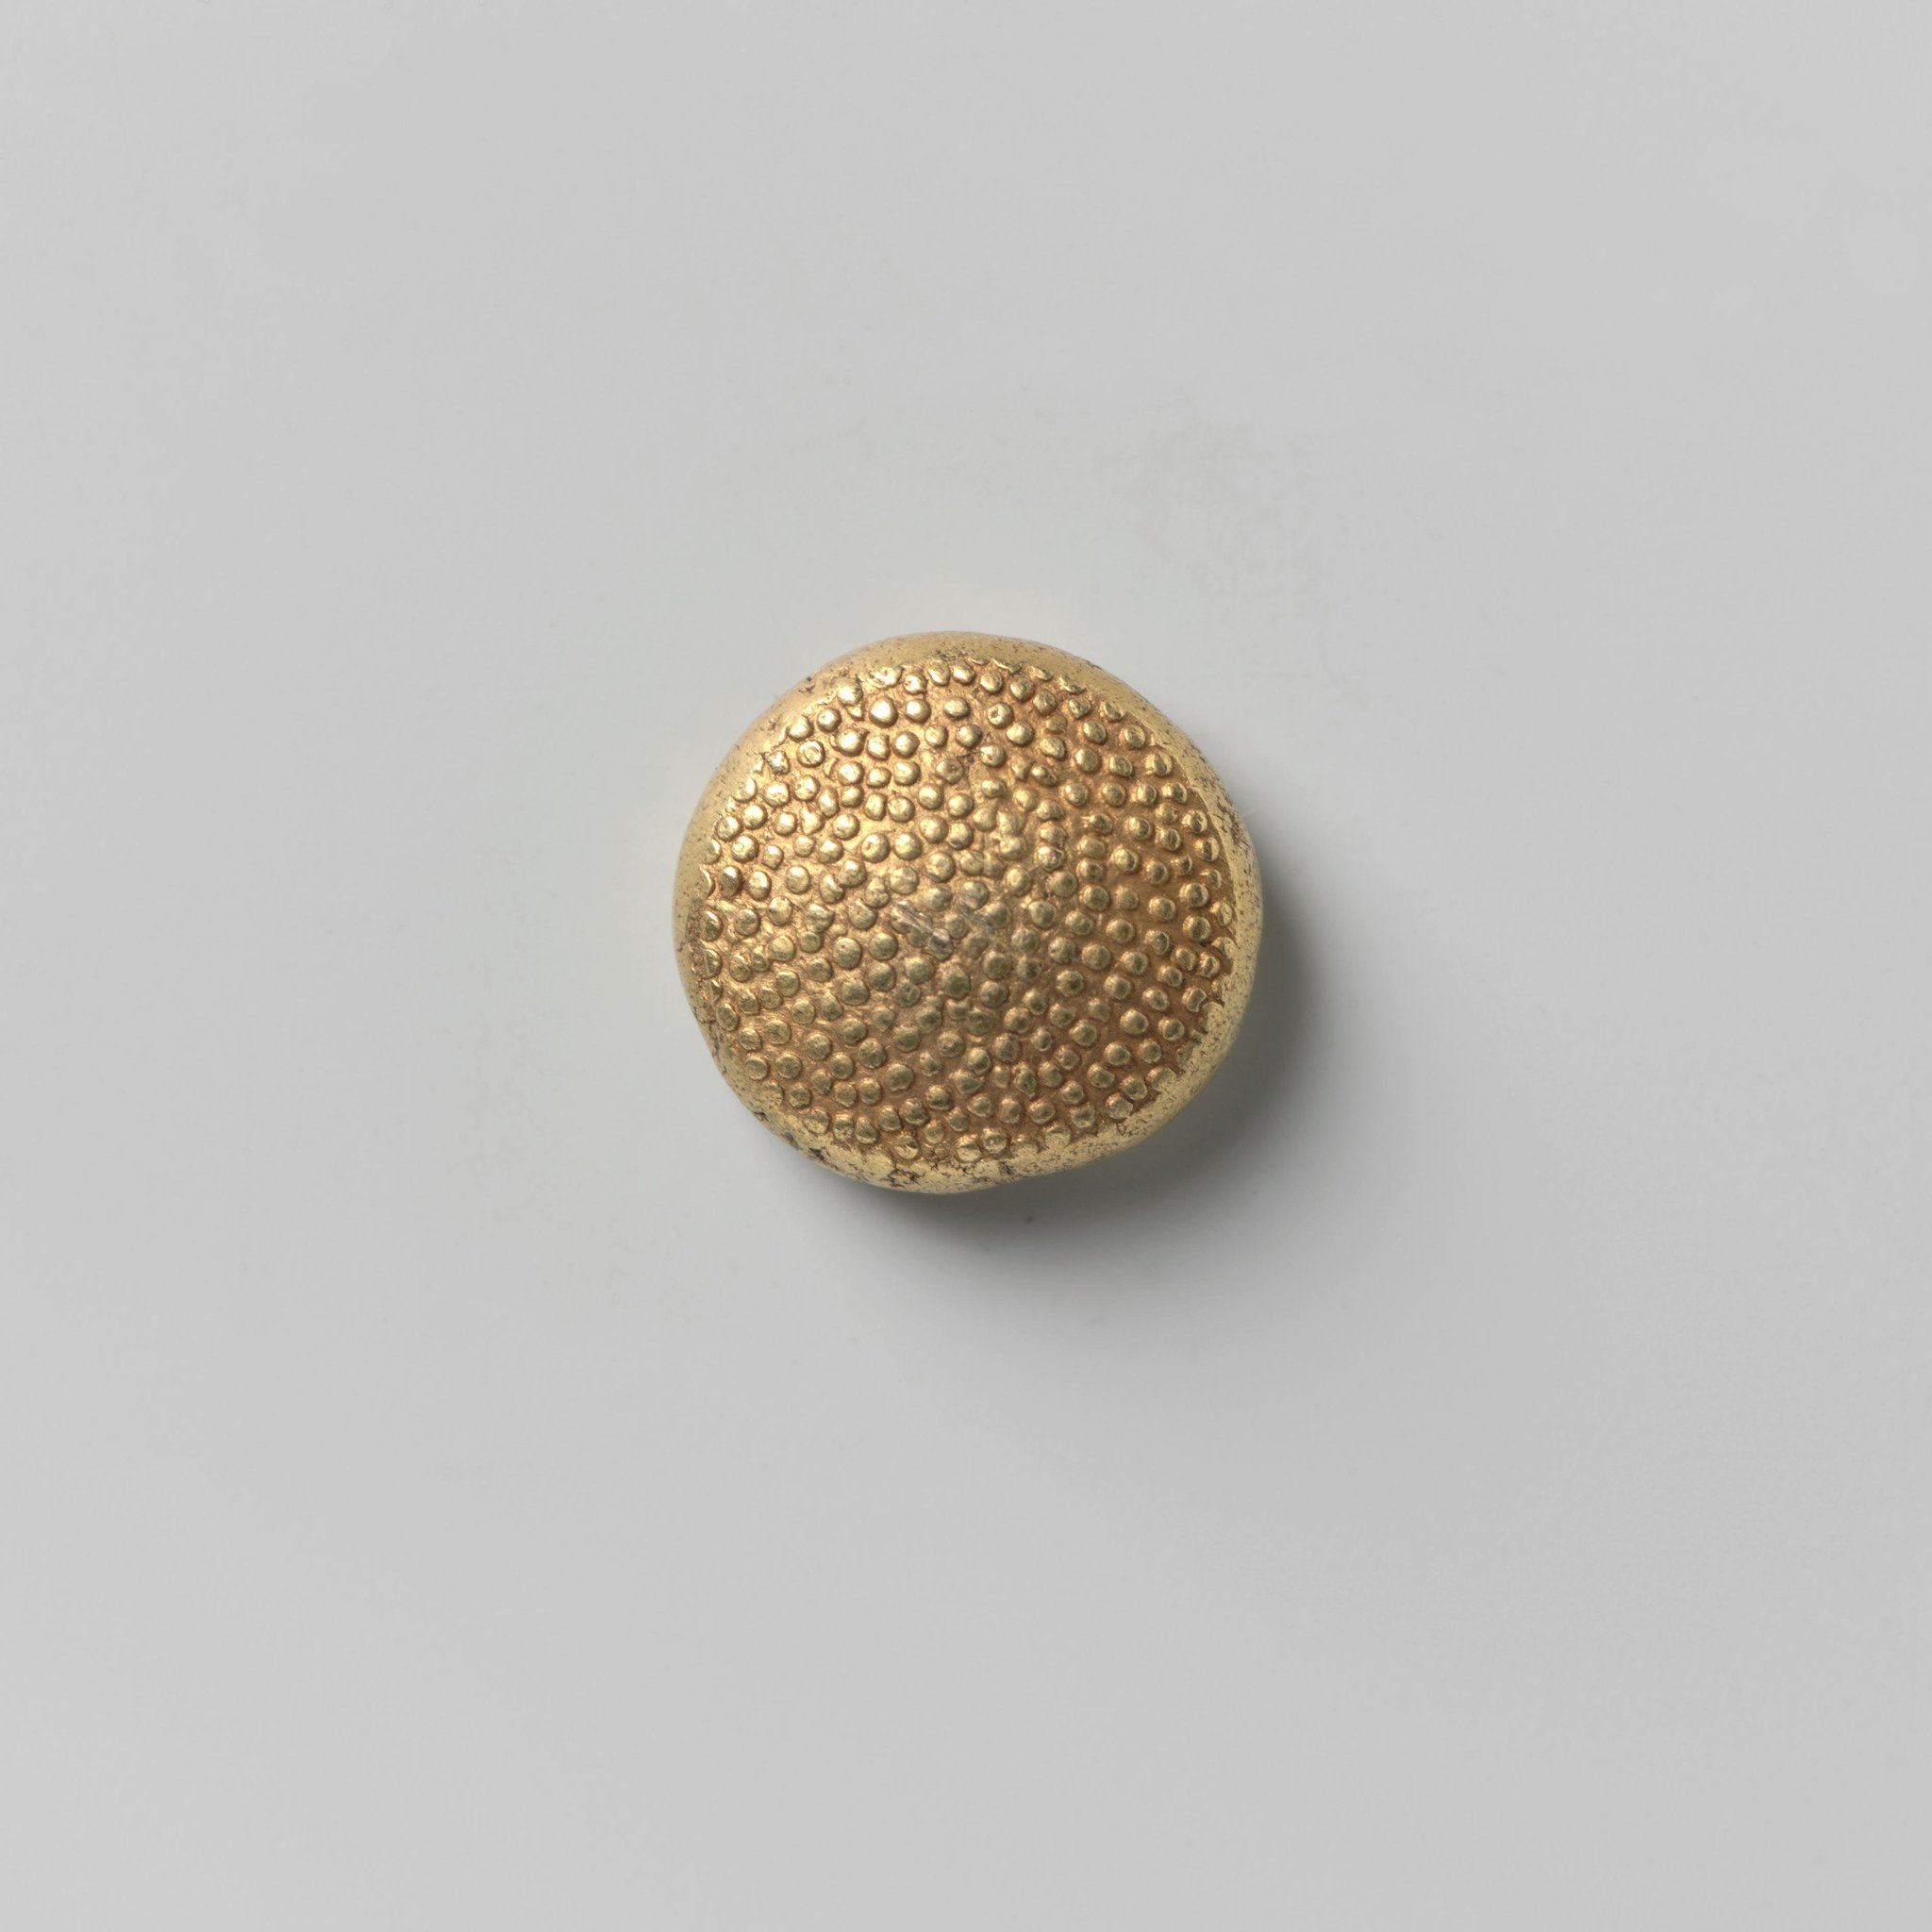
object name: pagode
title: Negapatnam, Voor-Indië, Porto Novo pagode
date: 1747-1781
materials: gold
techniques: striking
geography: negapatnam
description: Gouden munt. Voorzijde: de Godheid Vishnu staande met kegelvormige drievoudige kroon. Terzijde van het hoofd kleppen, waarnaast een verzameling punten. Keerzijde: bolvormig oppervlak, bezaaid met punten. Gladde rand.